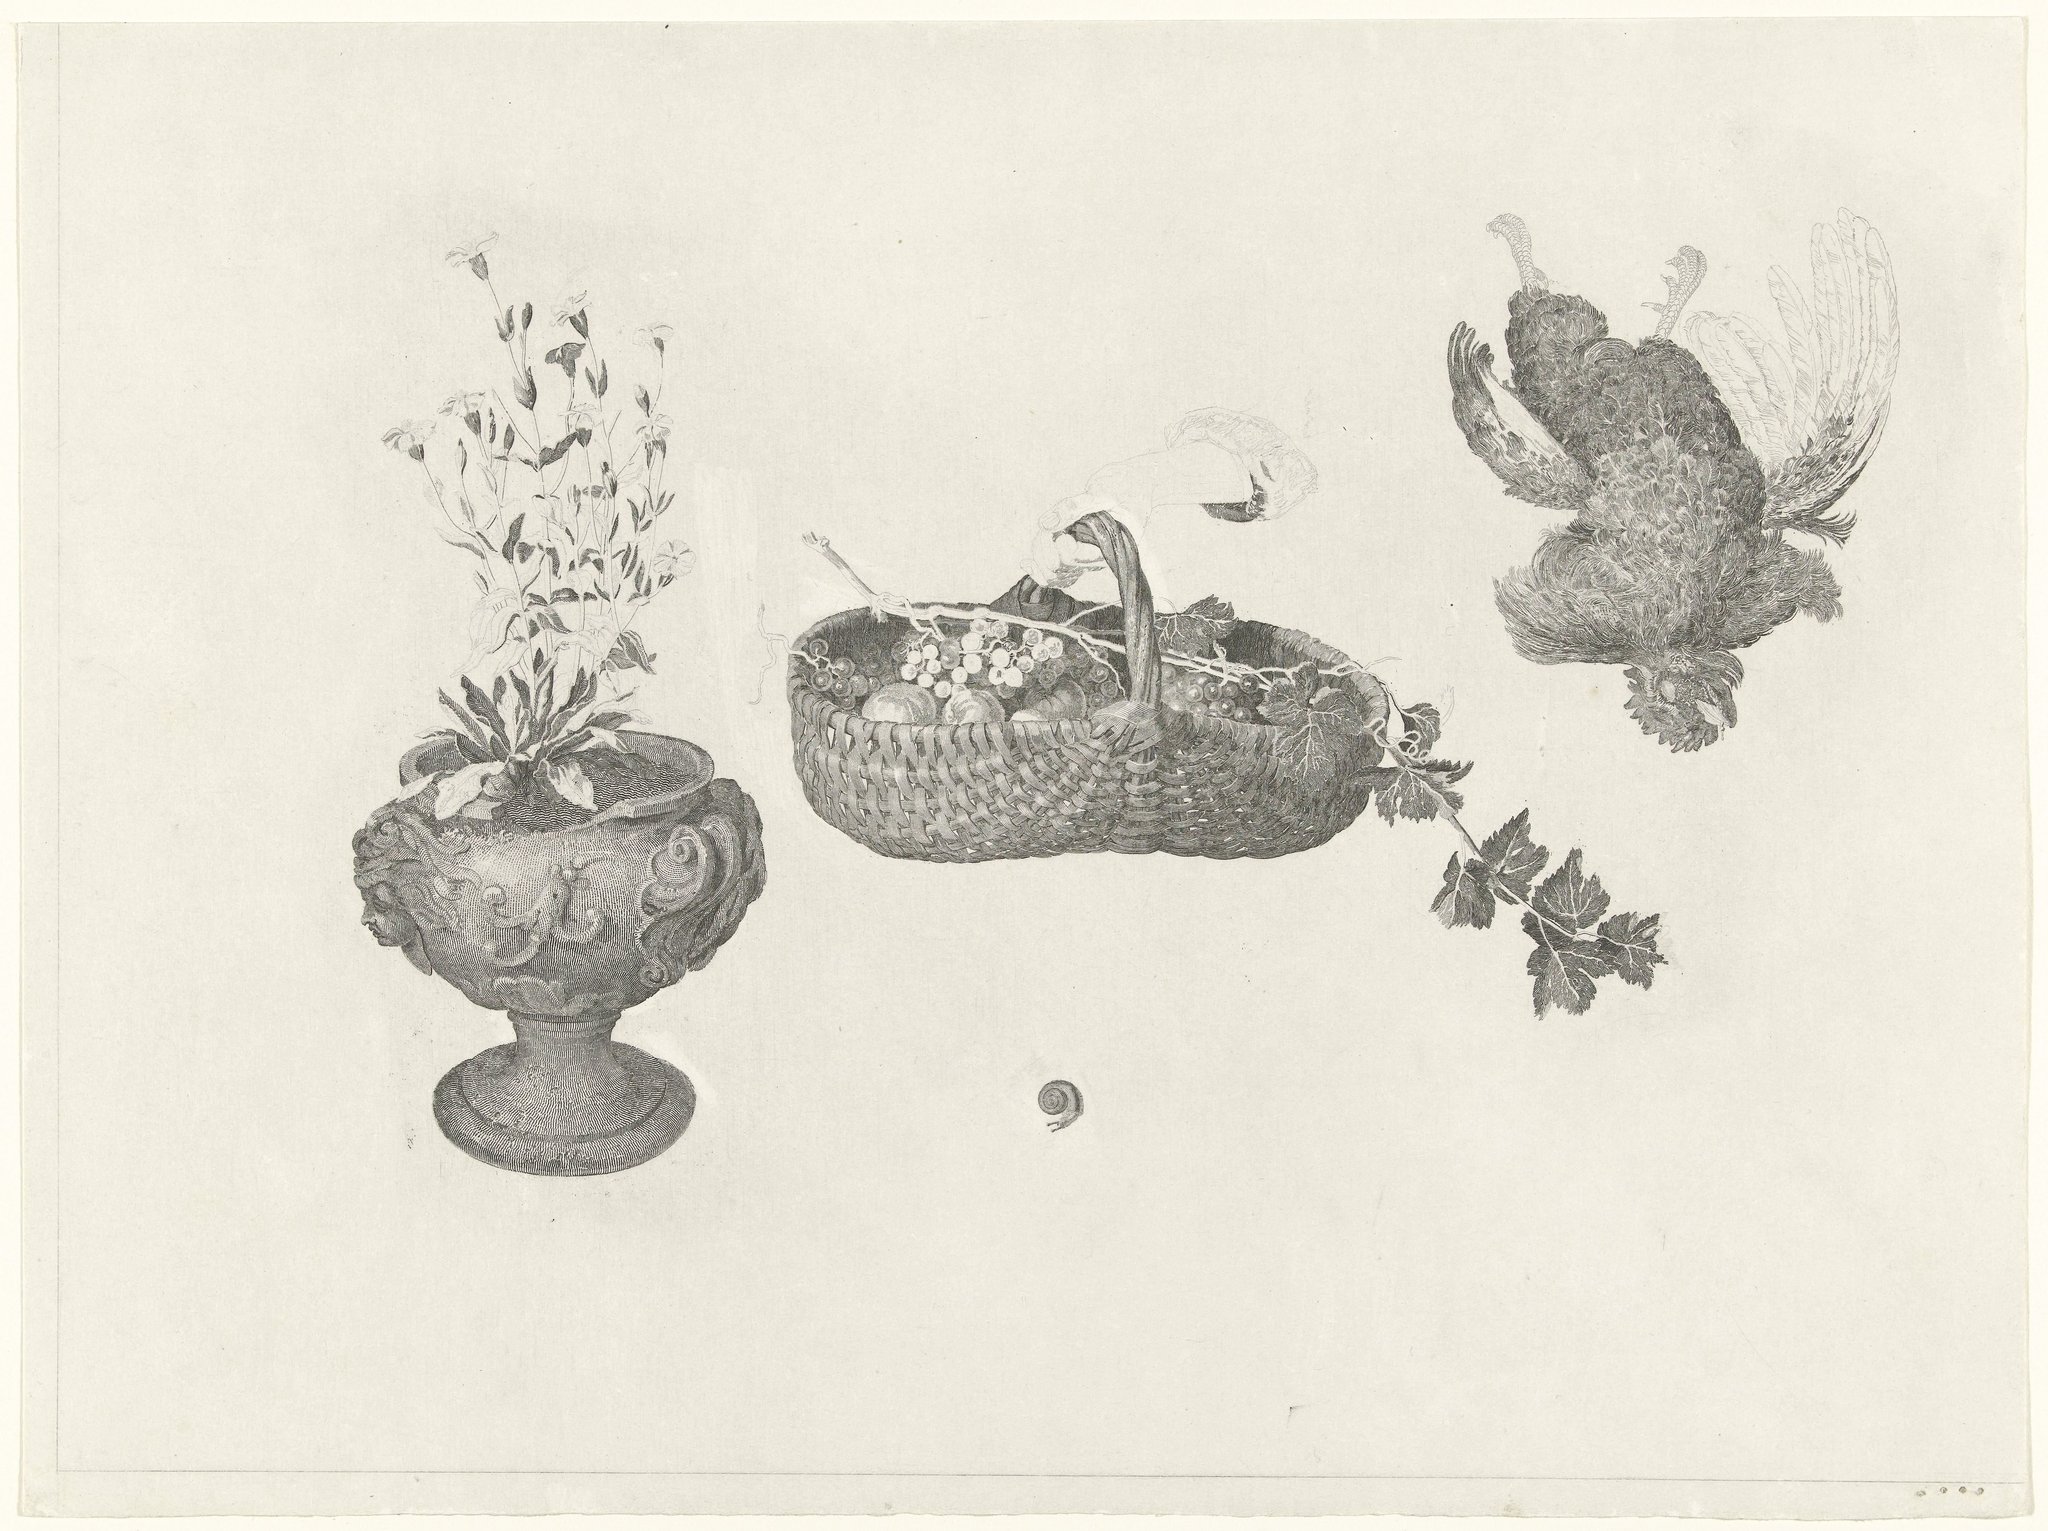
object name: print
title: Vrouw met mand met vruchten in de hand bij het raam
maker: henricus wilhelmus couwenberg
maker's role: draughtsman, print maker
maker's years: 1814-1845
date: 1840-1842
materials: paper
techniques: etching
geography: amsterdam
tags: human figure at (open) window, seen from outside, shop-window, show-window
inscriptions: collector's mark: Lugt 2228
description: Staat 1 tot 15 door Henricus Wilhelmus Couwenberg, staat 15 tot 24 door Johannes de Mare en staat 24 en 25 door Johann Wilhelm Kaiser.